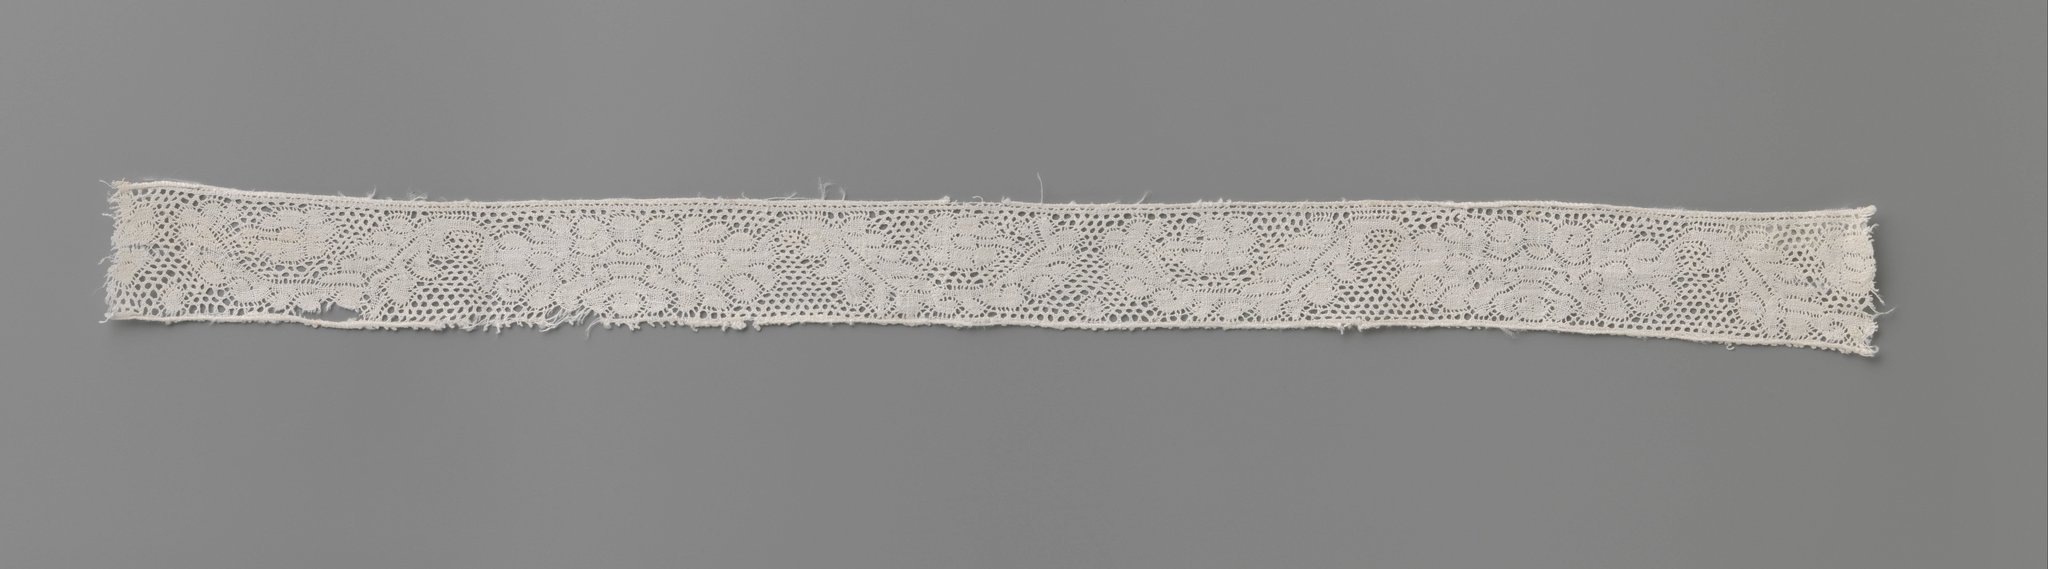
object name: strip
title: Strook kloskant met pioenroos tussen gebogen langgerekte bladeren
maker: Anonymous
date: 1650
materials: linen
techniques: lace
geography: antwerp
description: Strook naturelkleurige Hollandse kloskant. Het zich herhalende patroon bestaat een gestileerde pioenroos waaruit links en rechts een lang gebogen blad ontspringt met aan het einde een naar de pioenroos toegewende kleinere bloem. De motieven zijn met elkaar verbonden door een ronde traliegrond met vlechtslagen. De motieven zijn gemaakt in linnenslag, waarbij opengewerkte randjes zorgen voor contouren rond bloemblaadjes en bladnerven. Boven- en onderzijde van de strook zijn recht afgewerkt.